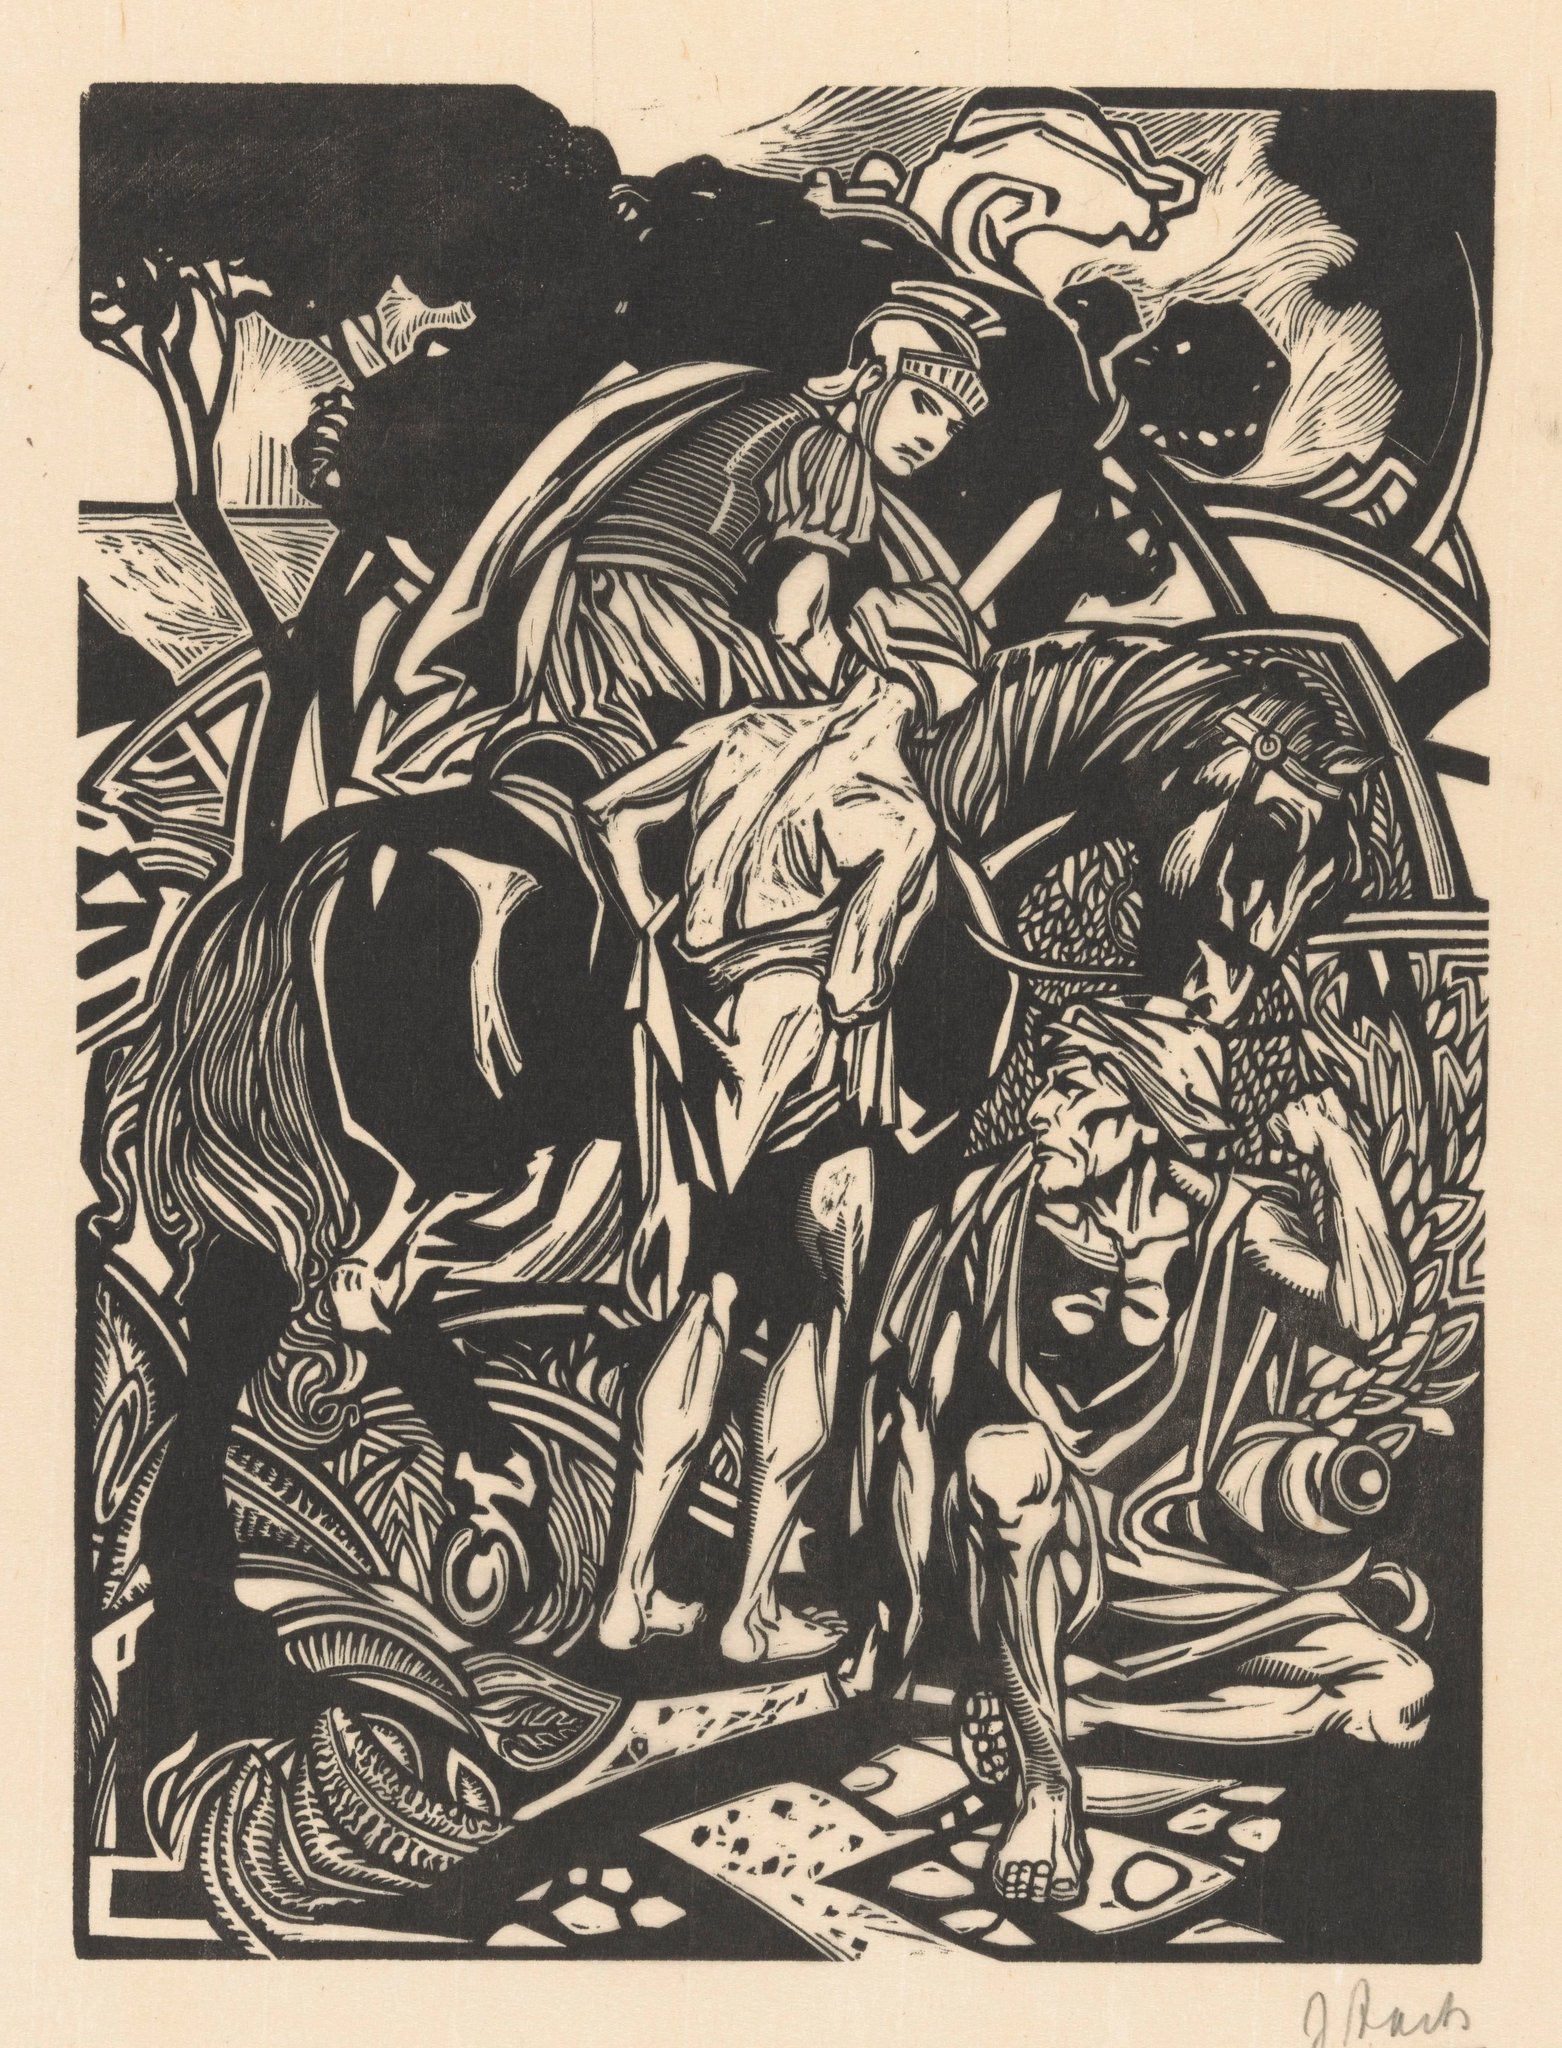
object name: print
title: Romeinse ruiter te paard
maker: johannes josephus aarts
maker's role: draughtsman, print maker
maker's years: 1871-1934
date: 1881-1931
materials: paper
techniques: woodcut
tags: warfare; military affairs (+ cavalry, horsemen), martin(us), bishop of tours; possible attributes: beggar, goose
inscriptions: collector's mark: Lugt 2228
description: Een ruiter met zwaard en Romeinse helm op een paard. Naast hem een staande en een zittende man, beiden halfnaakt.